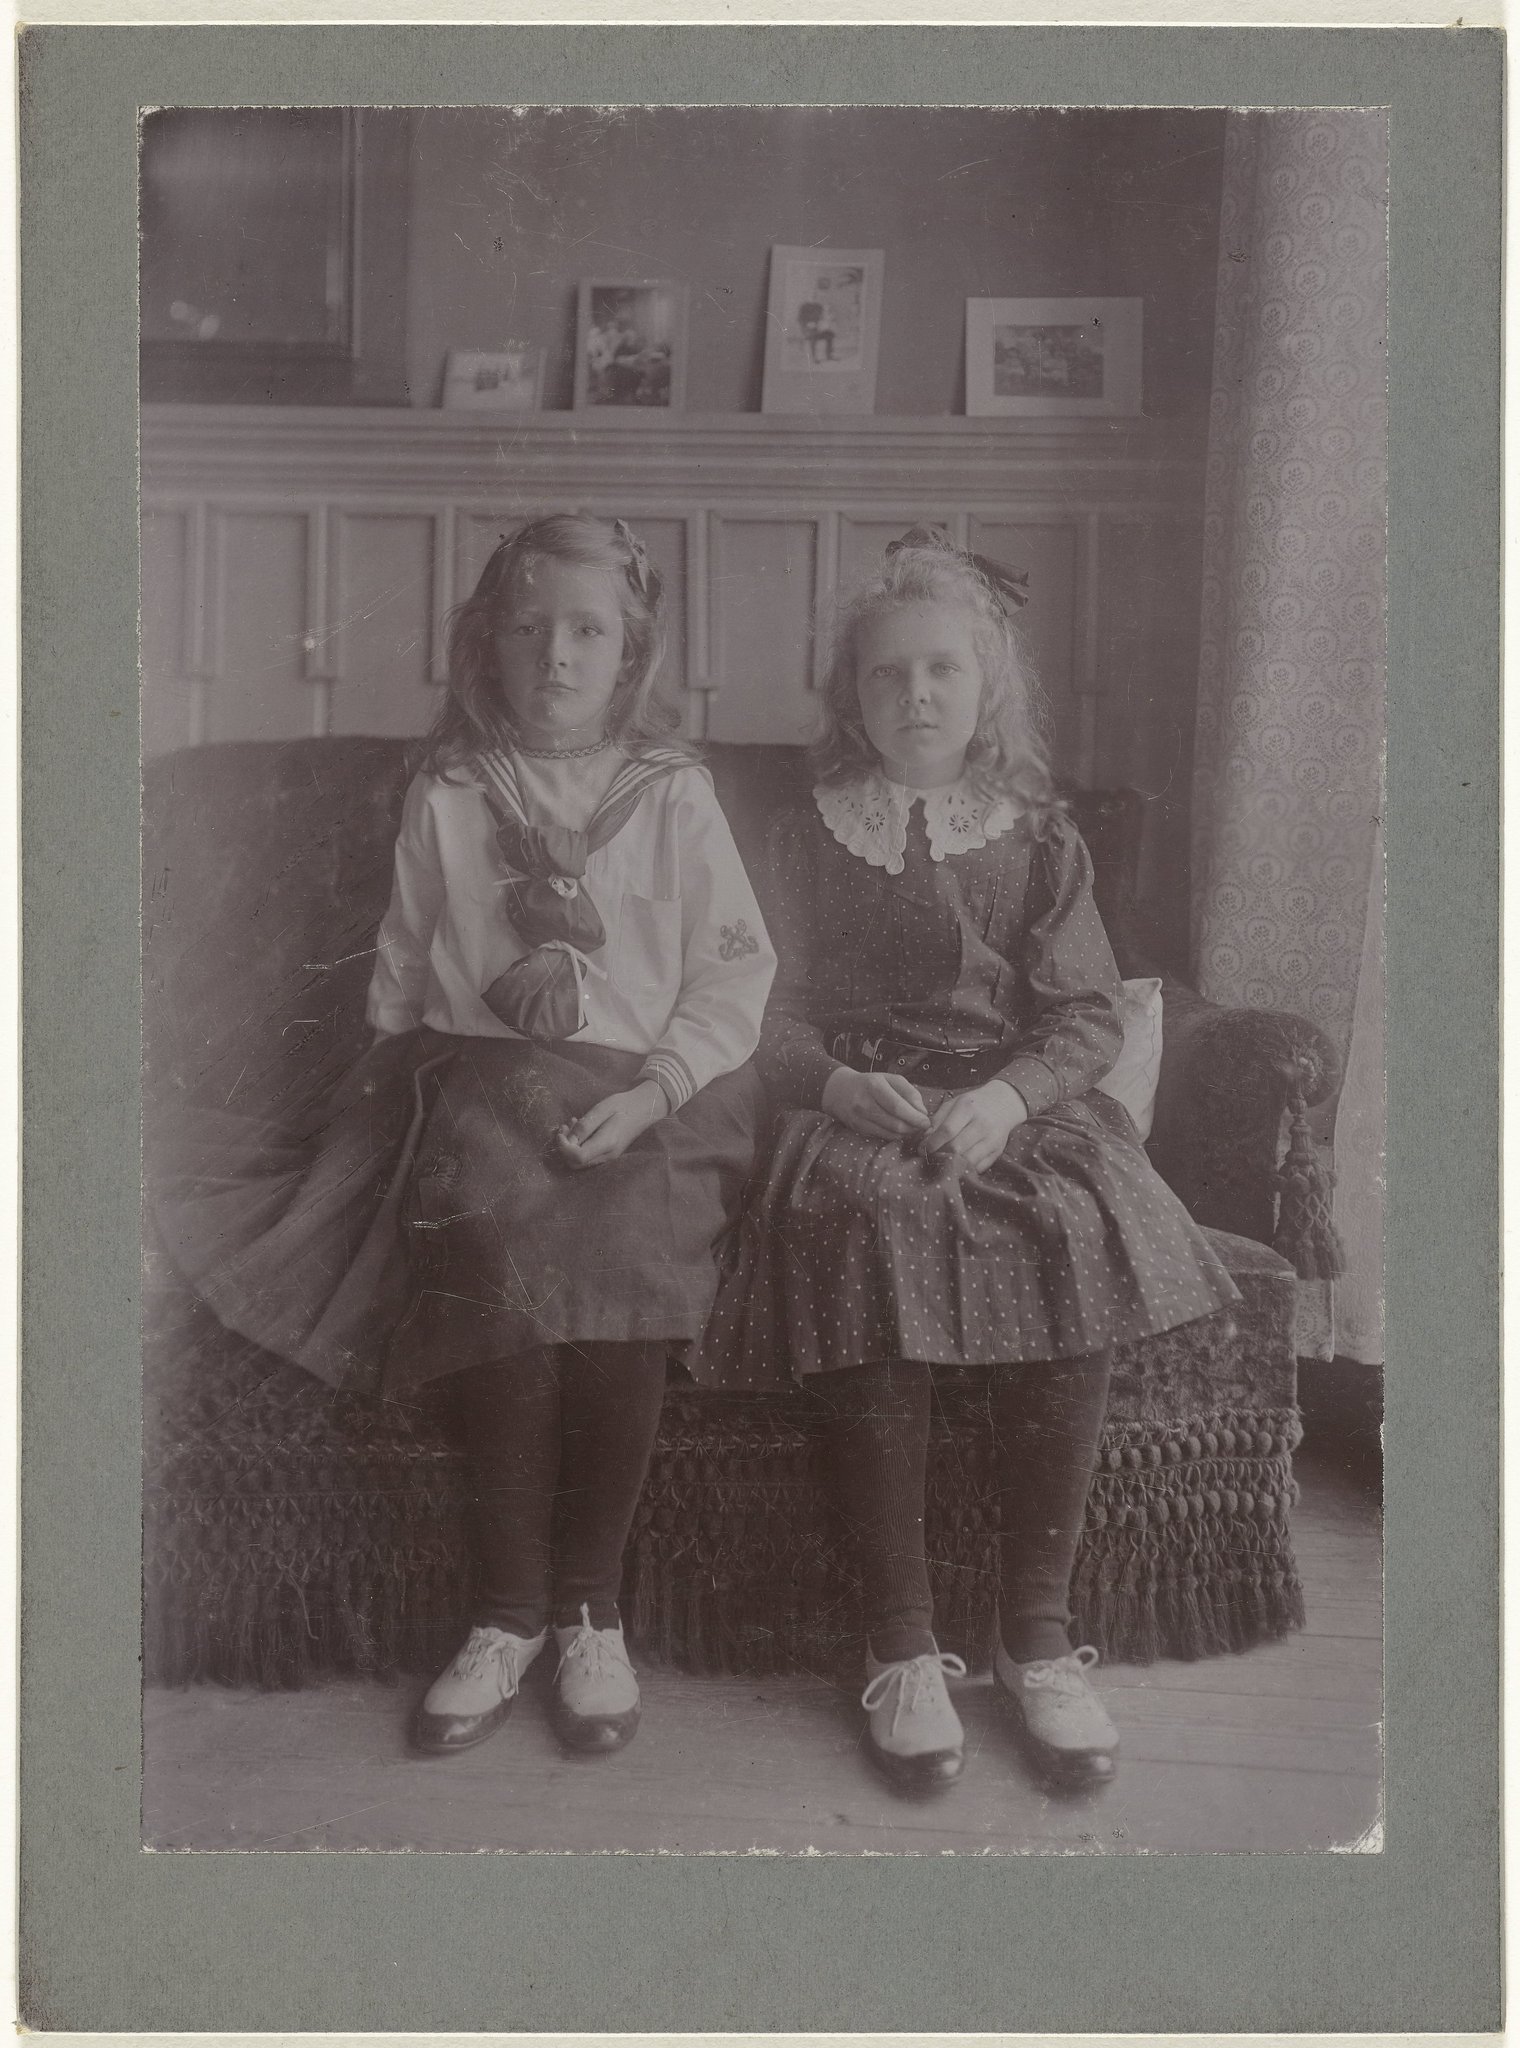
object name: photograph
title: Portret van twee meisjes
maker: henry pauw van wieldrecht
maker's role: fotograaf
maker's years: 1863-1912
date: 1910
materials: cardboard, photographic support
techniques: gelatin silver print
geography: netherlands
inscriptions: annotation: ‘No 3718. / 1910.’